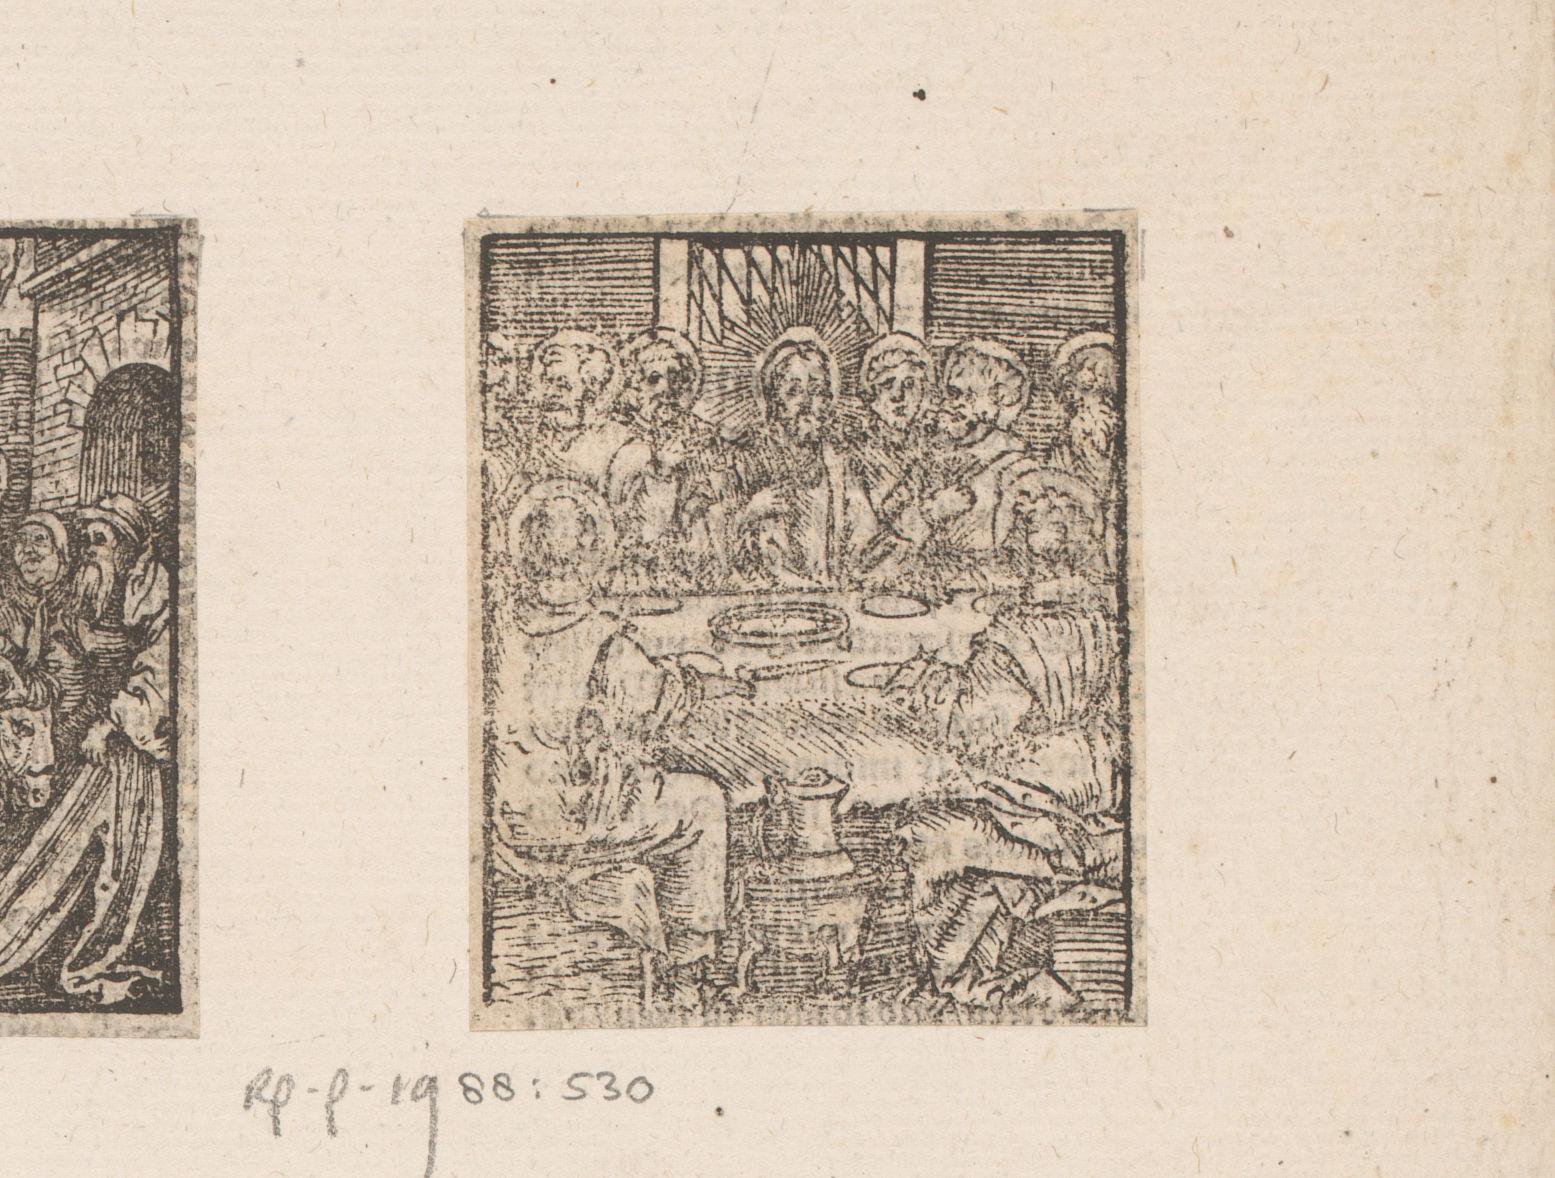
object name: book illustration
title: Laatste Avondmaal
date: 1536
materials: paper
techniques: woodcut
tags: last supper (in general) (matthew 26:21-35; mark 14:18-31; luke 22:3, 22:15-23; john 13:21-38)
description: Prent afkomstig uit: Evangelia und Epistel. Neurenberg: Hans Guldenmund, 1536.